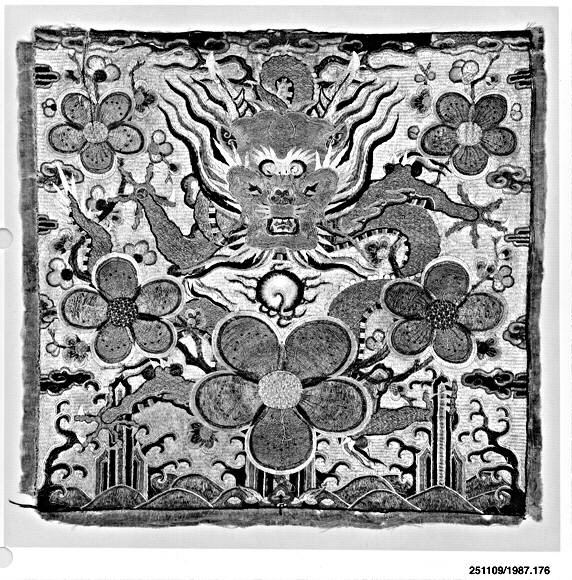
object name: badge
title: Badge with Five-Clawed Dragon Surrounded by Plum Blossoms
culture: chinese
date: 1567-1633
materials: metal thread, silk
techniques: embroidery, weave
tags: dragons